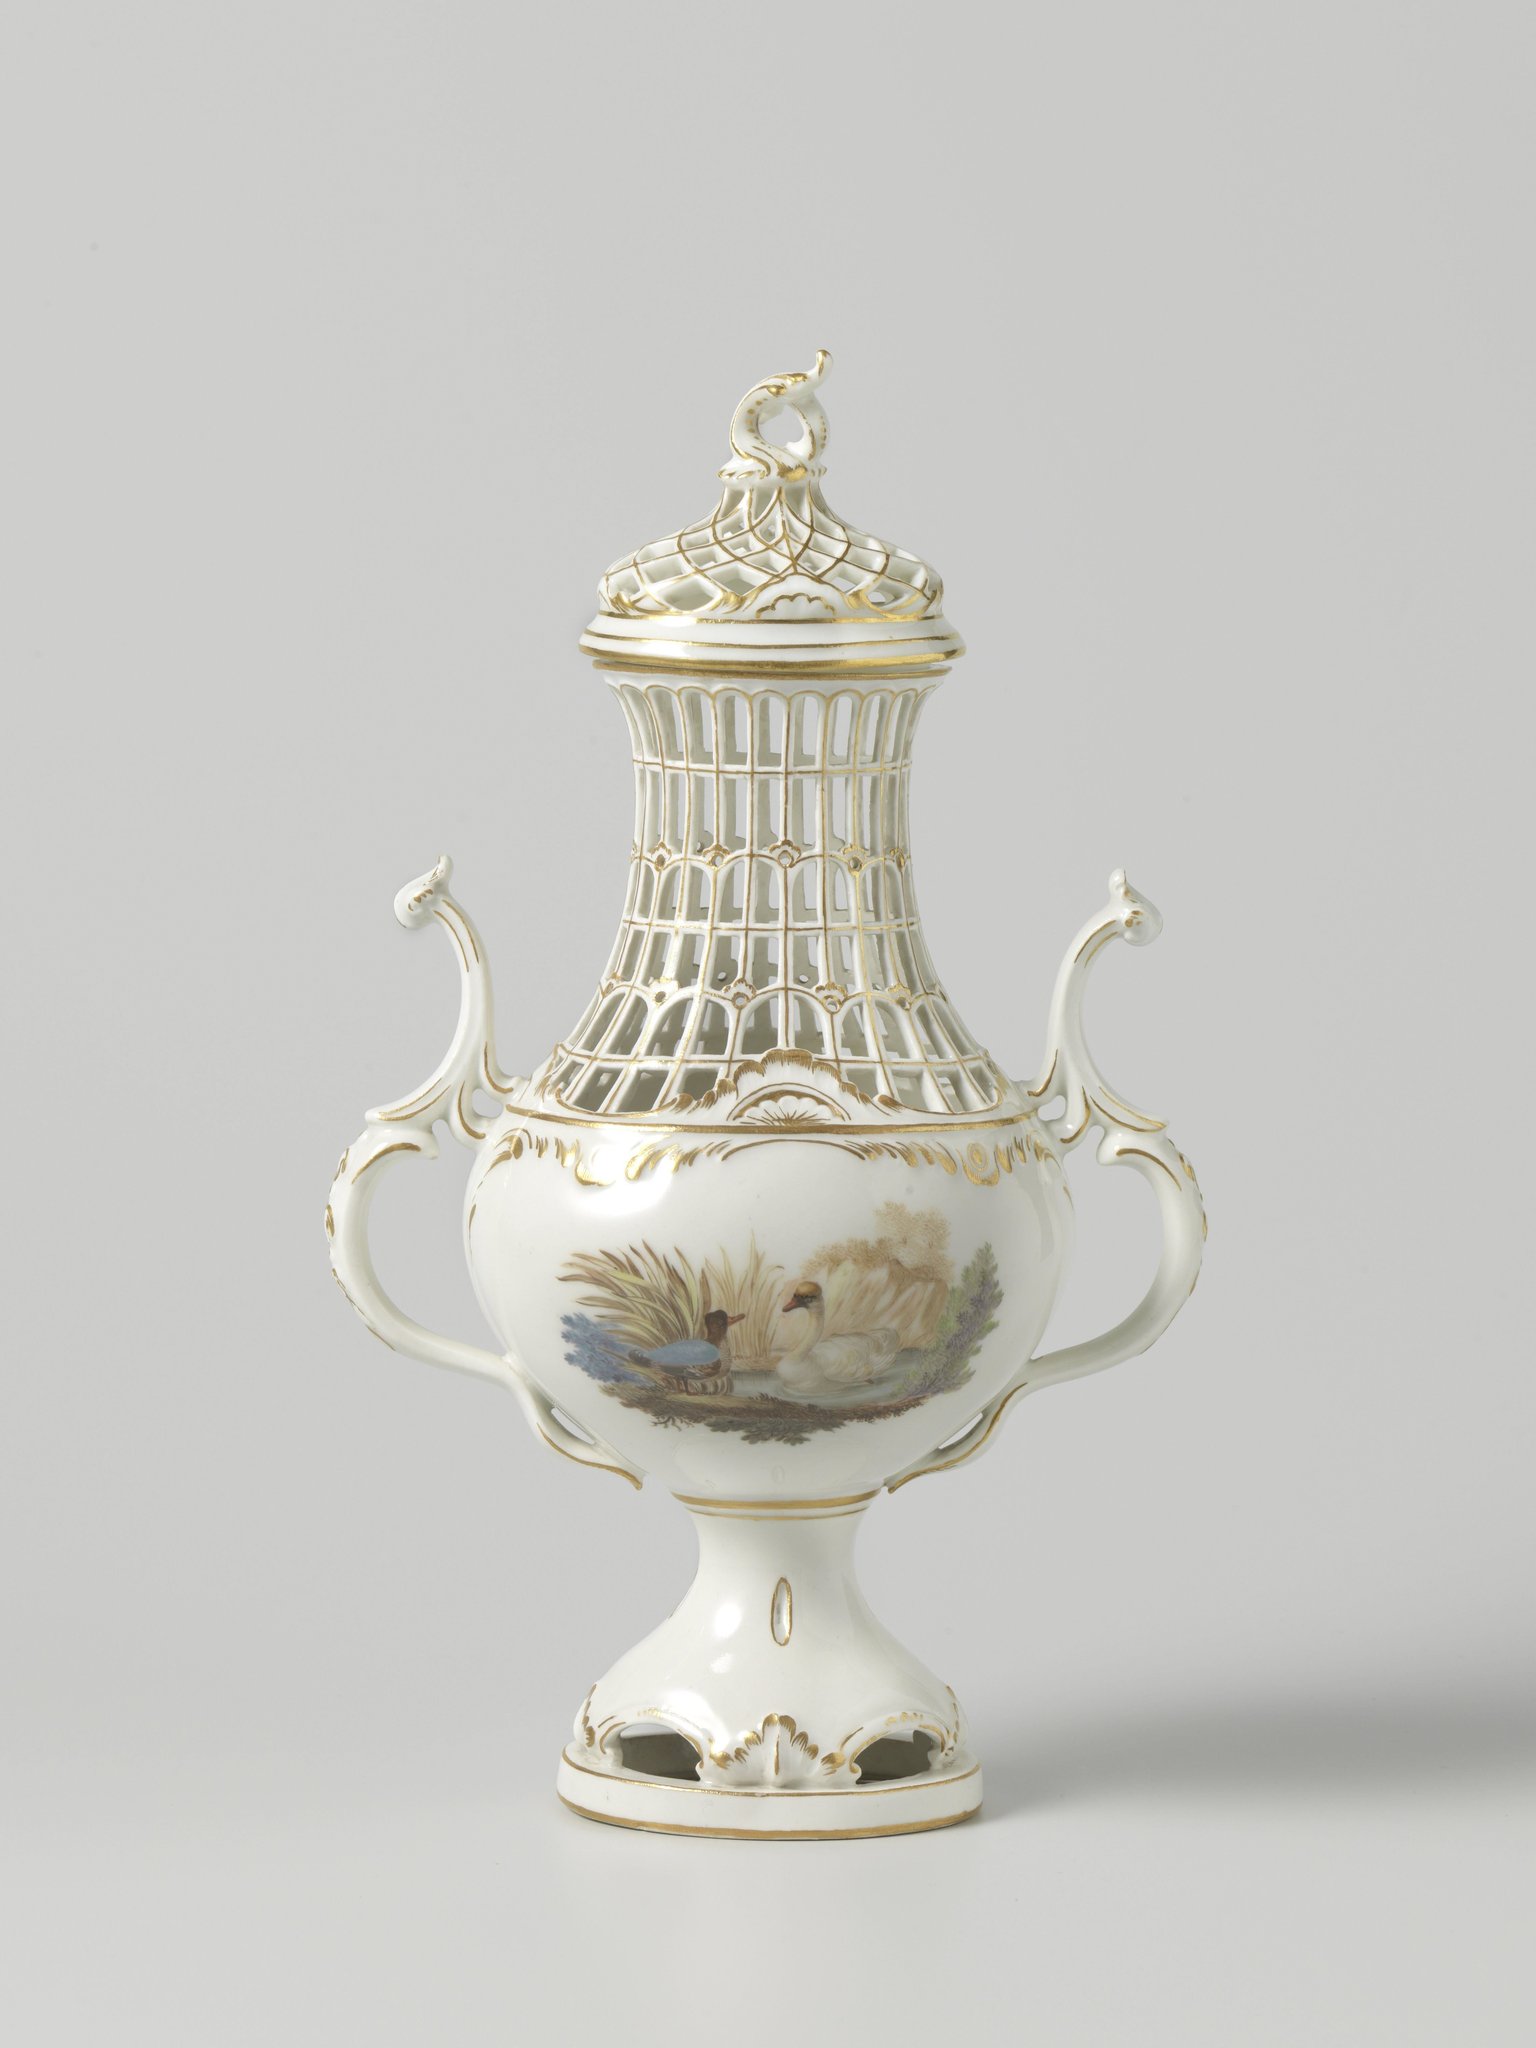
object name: vase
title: Group of vases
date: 1784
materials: porcelain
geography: ouderkerk aan de amstel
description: Two of the vases in this group bear the mark of the Porceleinfabriek aan den Amstel, the successor of the Loosdrecht porcelain factory. Just as the factory at Loosdrecht had earlier bought up the stock and moulds of its predecessor in Weesp, so did the factory in Ouderkerk aan de Amstel take over the inventory of Loosdrecht.